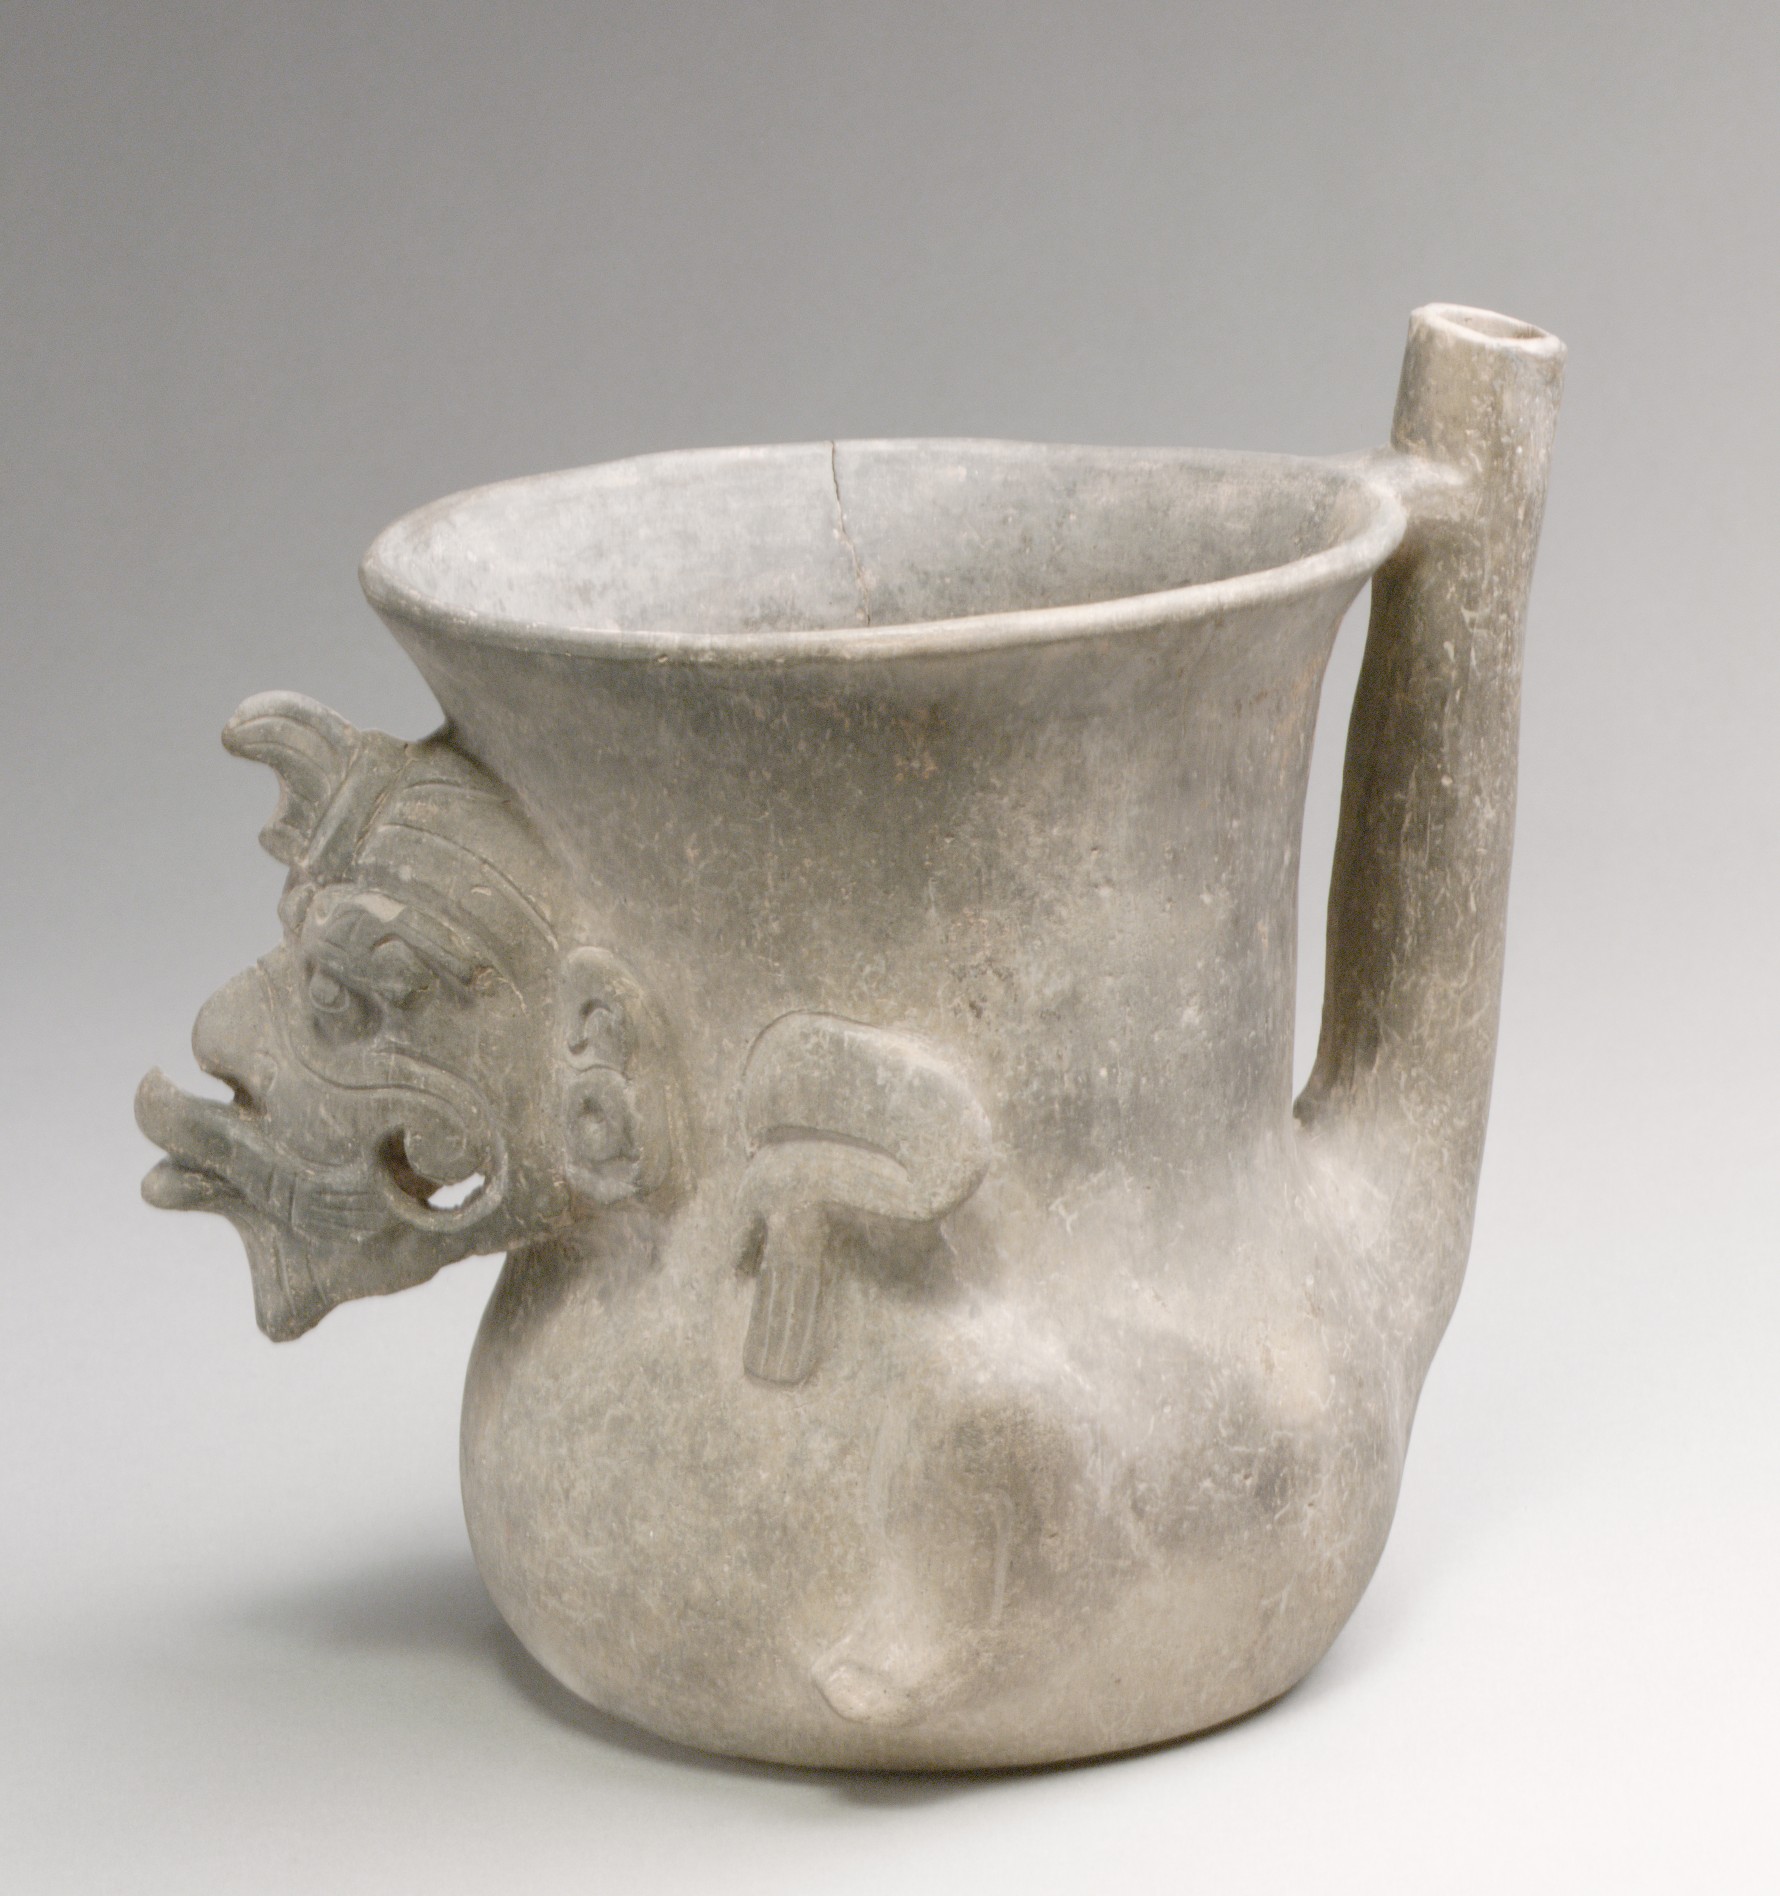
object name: jar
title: Spouted jar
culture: monte alban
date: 300-1 BCE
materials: ceramic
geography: mexico